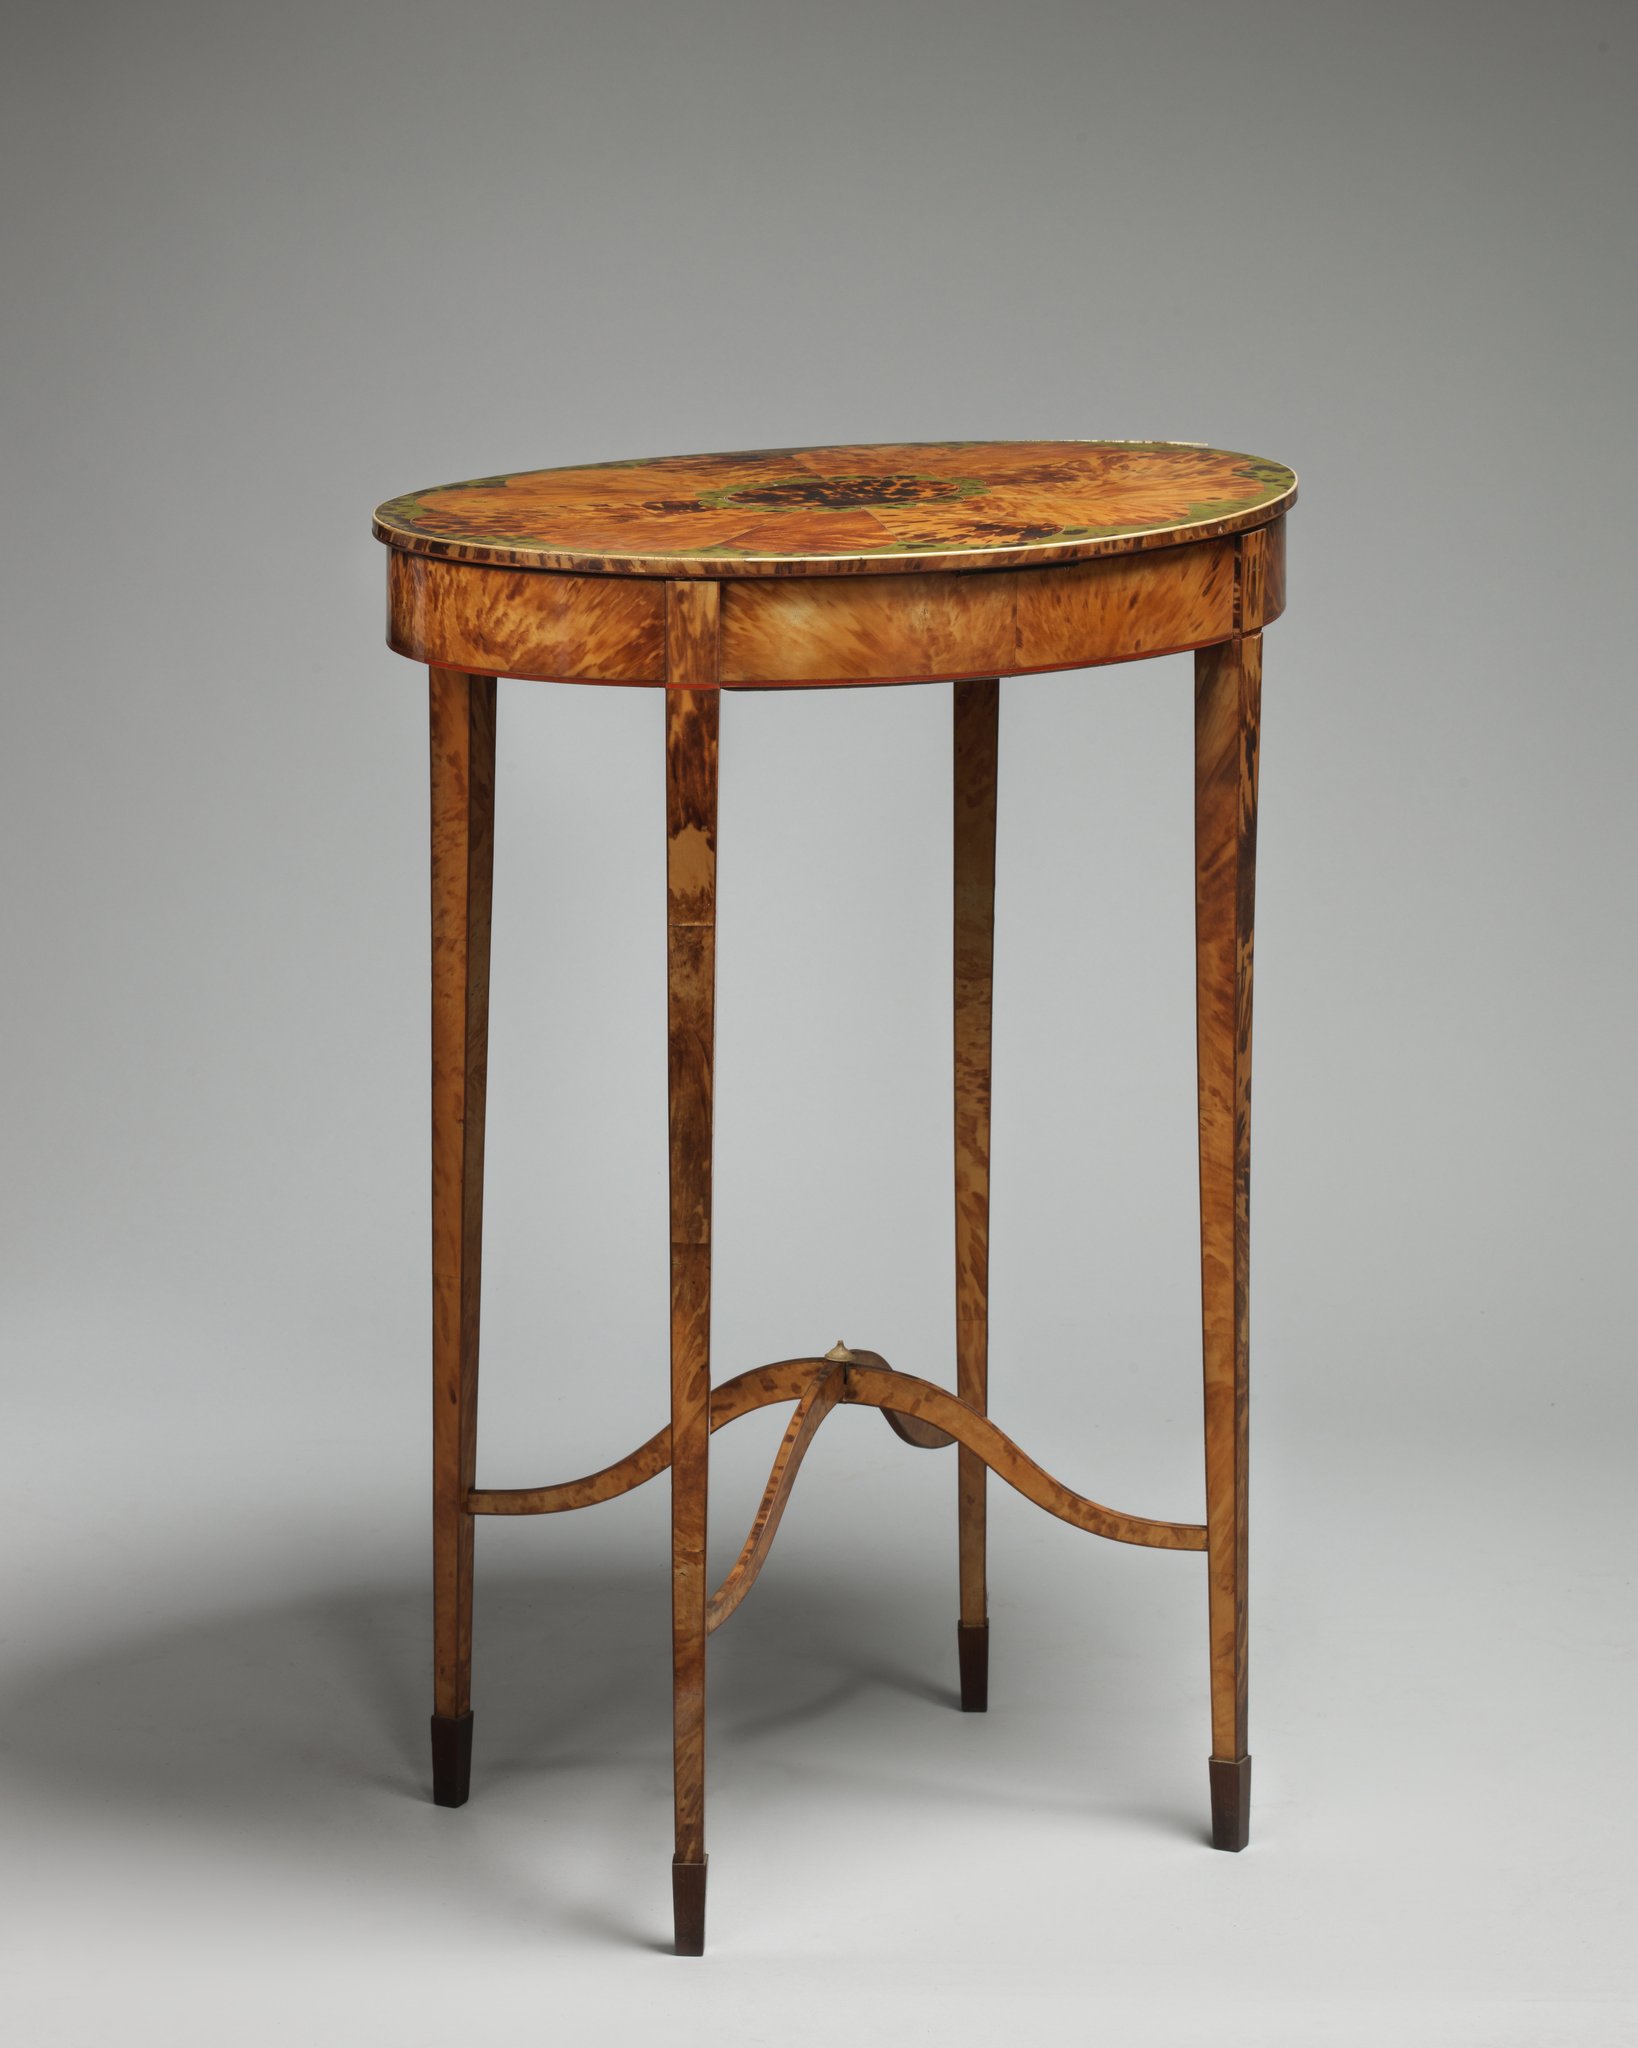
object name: work table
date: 1767-1800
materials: shell, wood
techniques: veneering